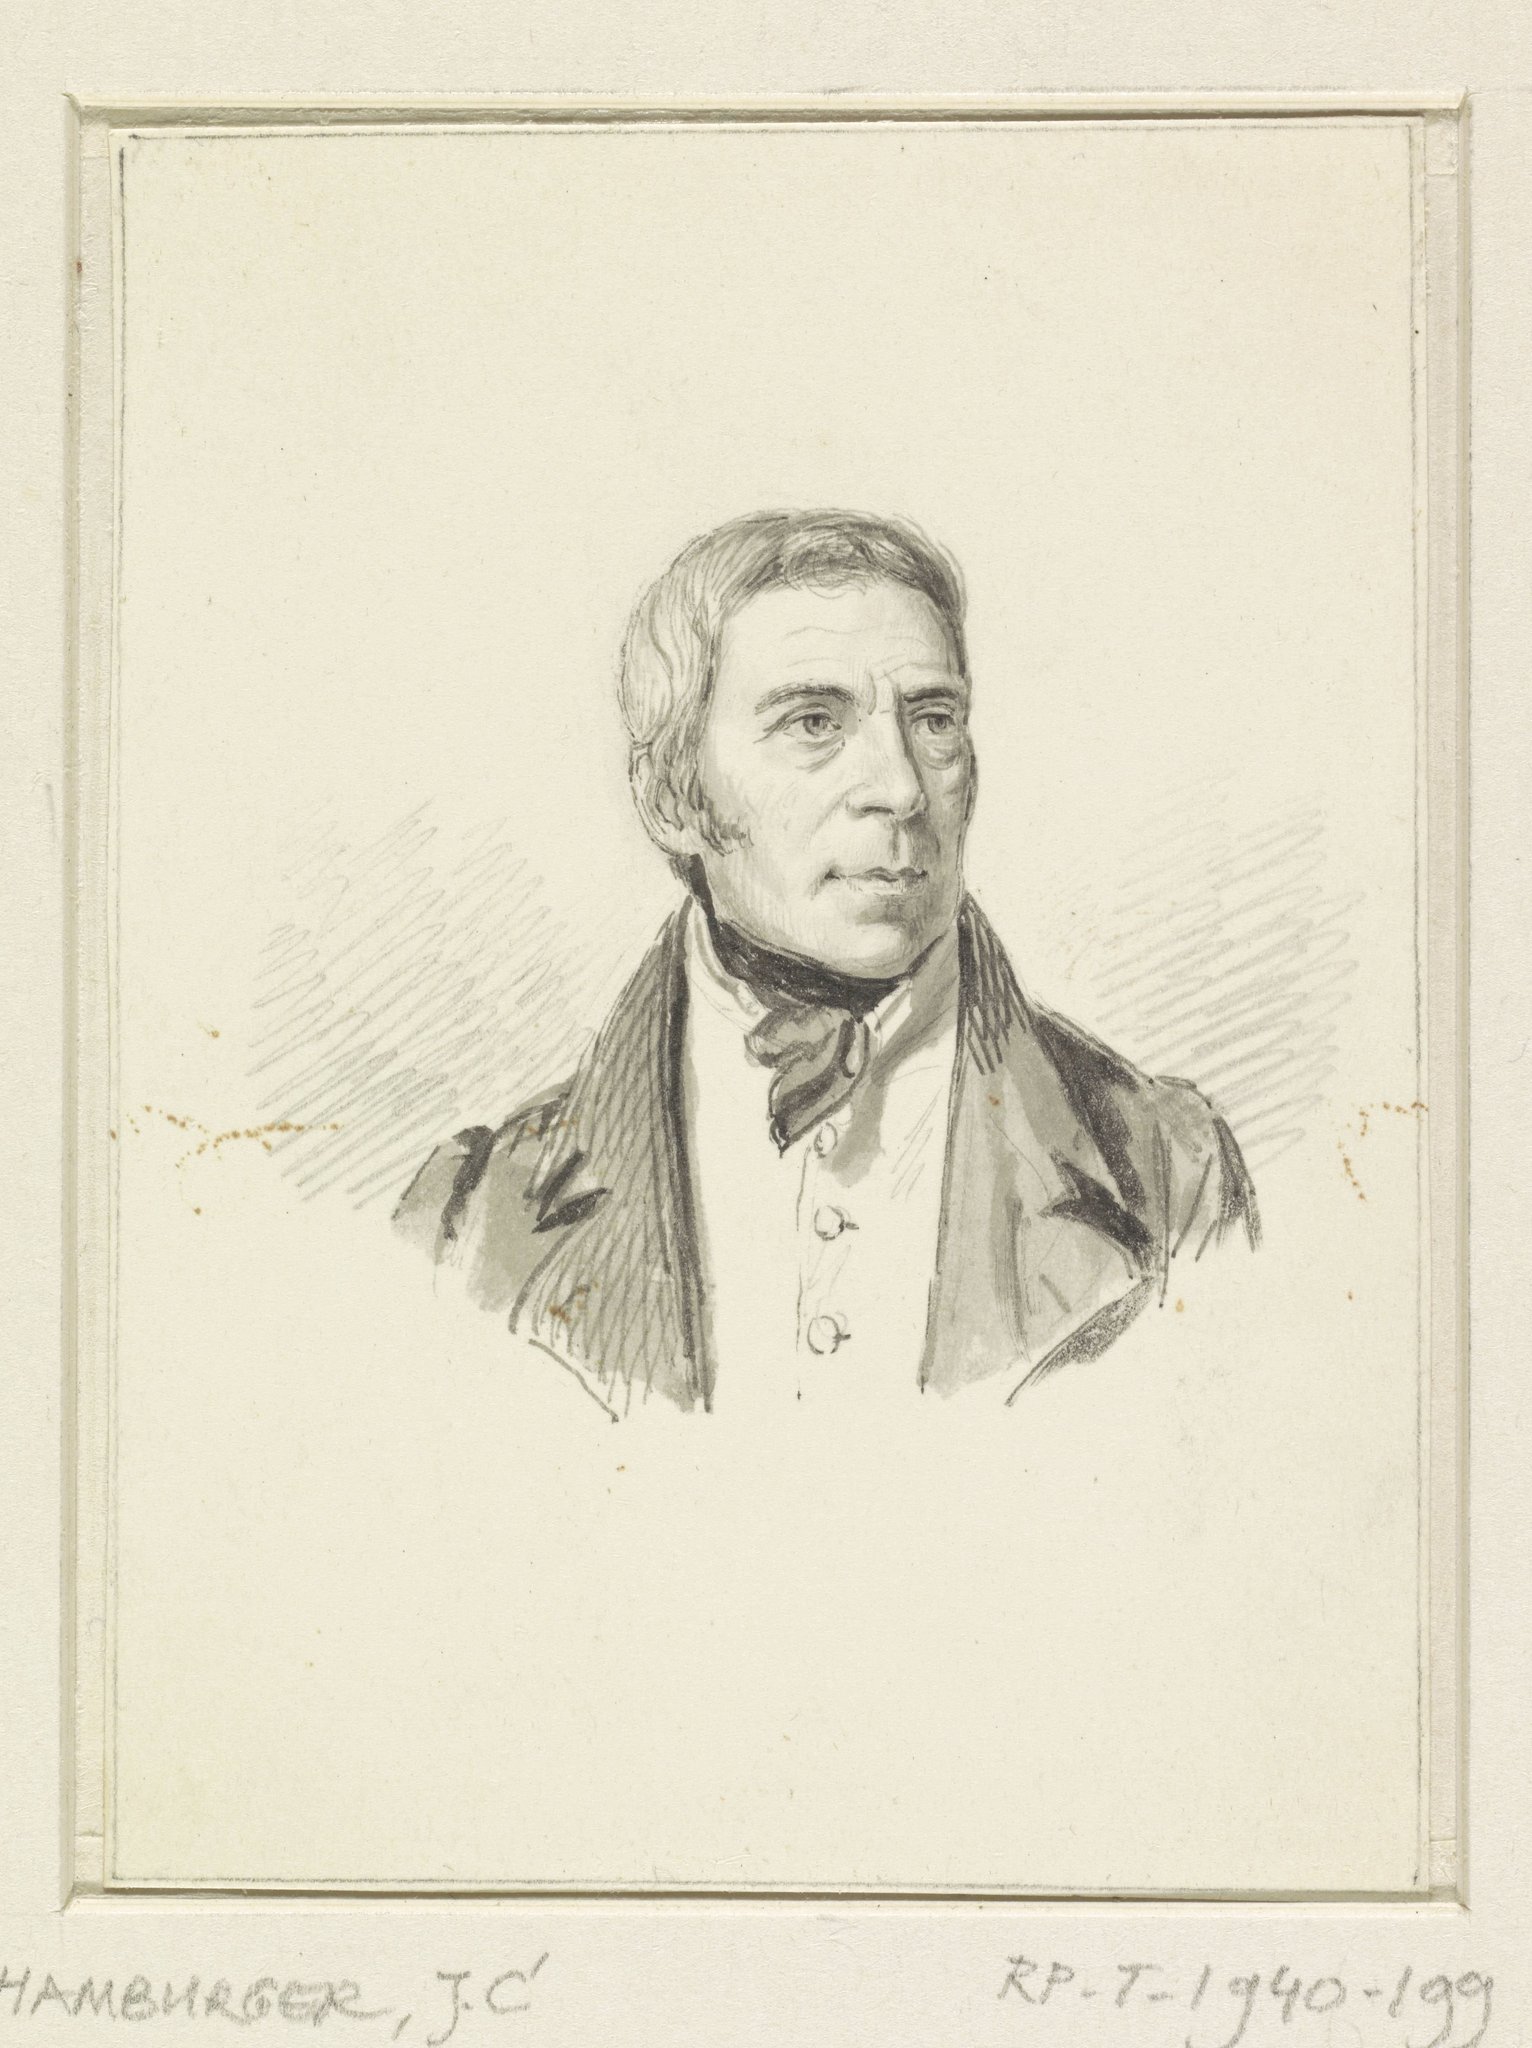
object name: drawing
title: Portret van Leendert de Koningh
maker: coenraad hamburger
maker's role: draughtsman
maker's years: 1809-1891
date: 1819-1871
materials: ink, paper, pencil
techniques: pen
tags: dordrecht, print maker, draughtsman, leendert de koningh, historical persons, portrait, self-portrait of artist